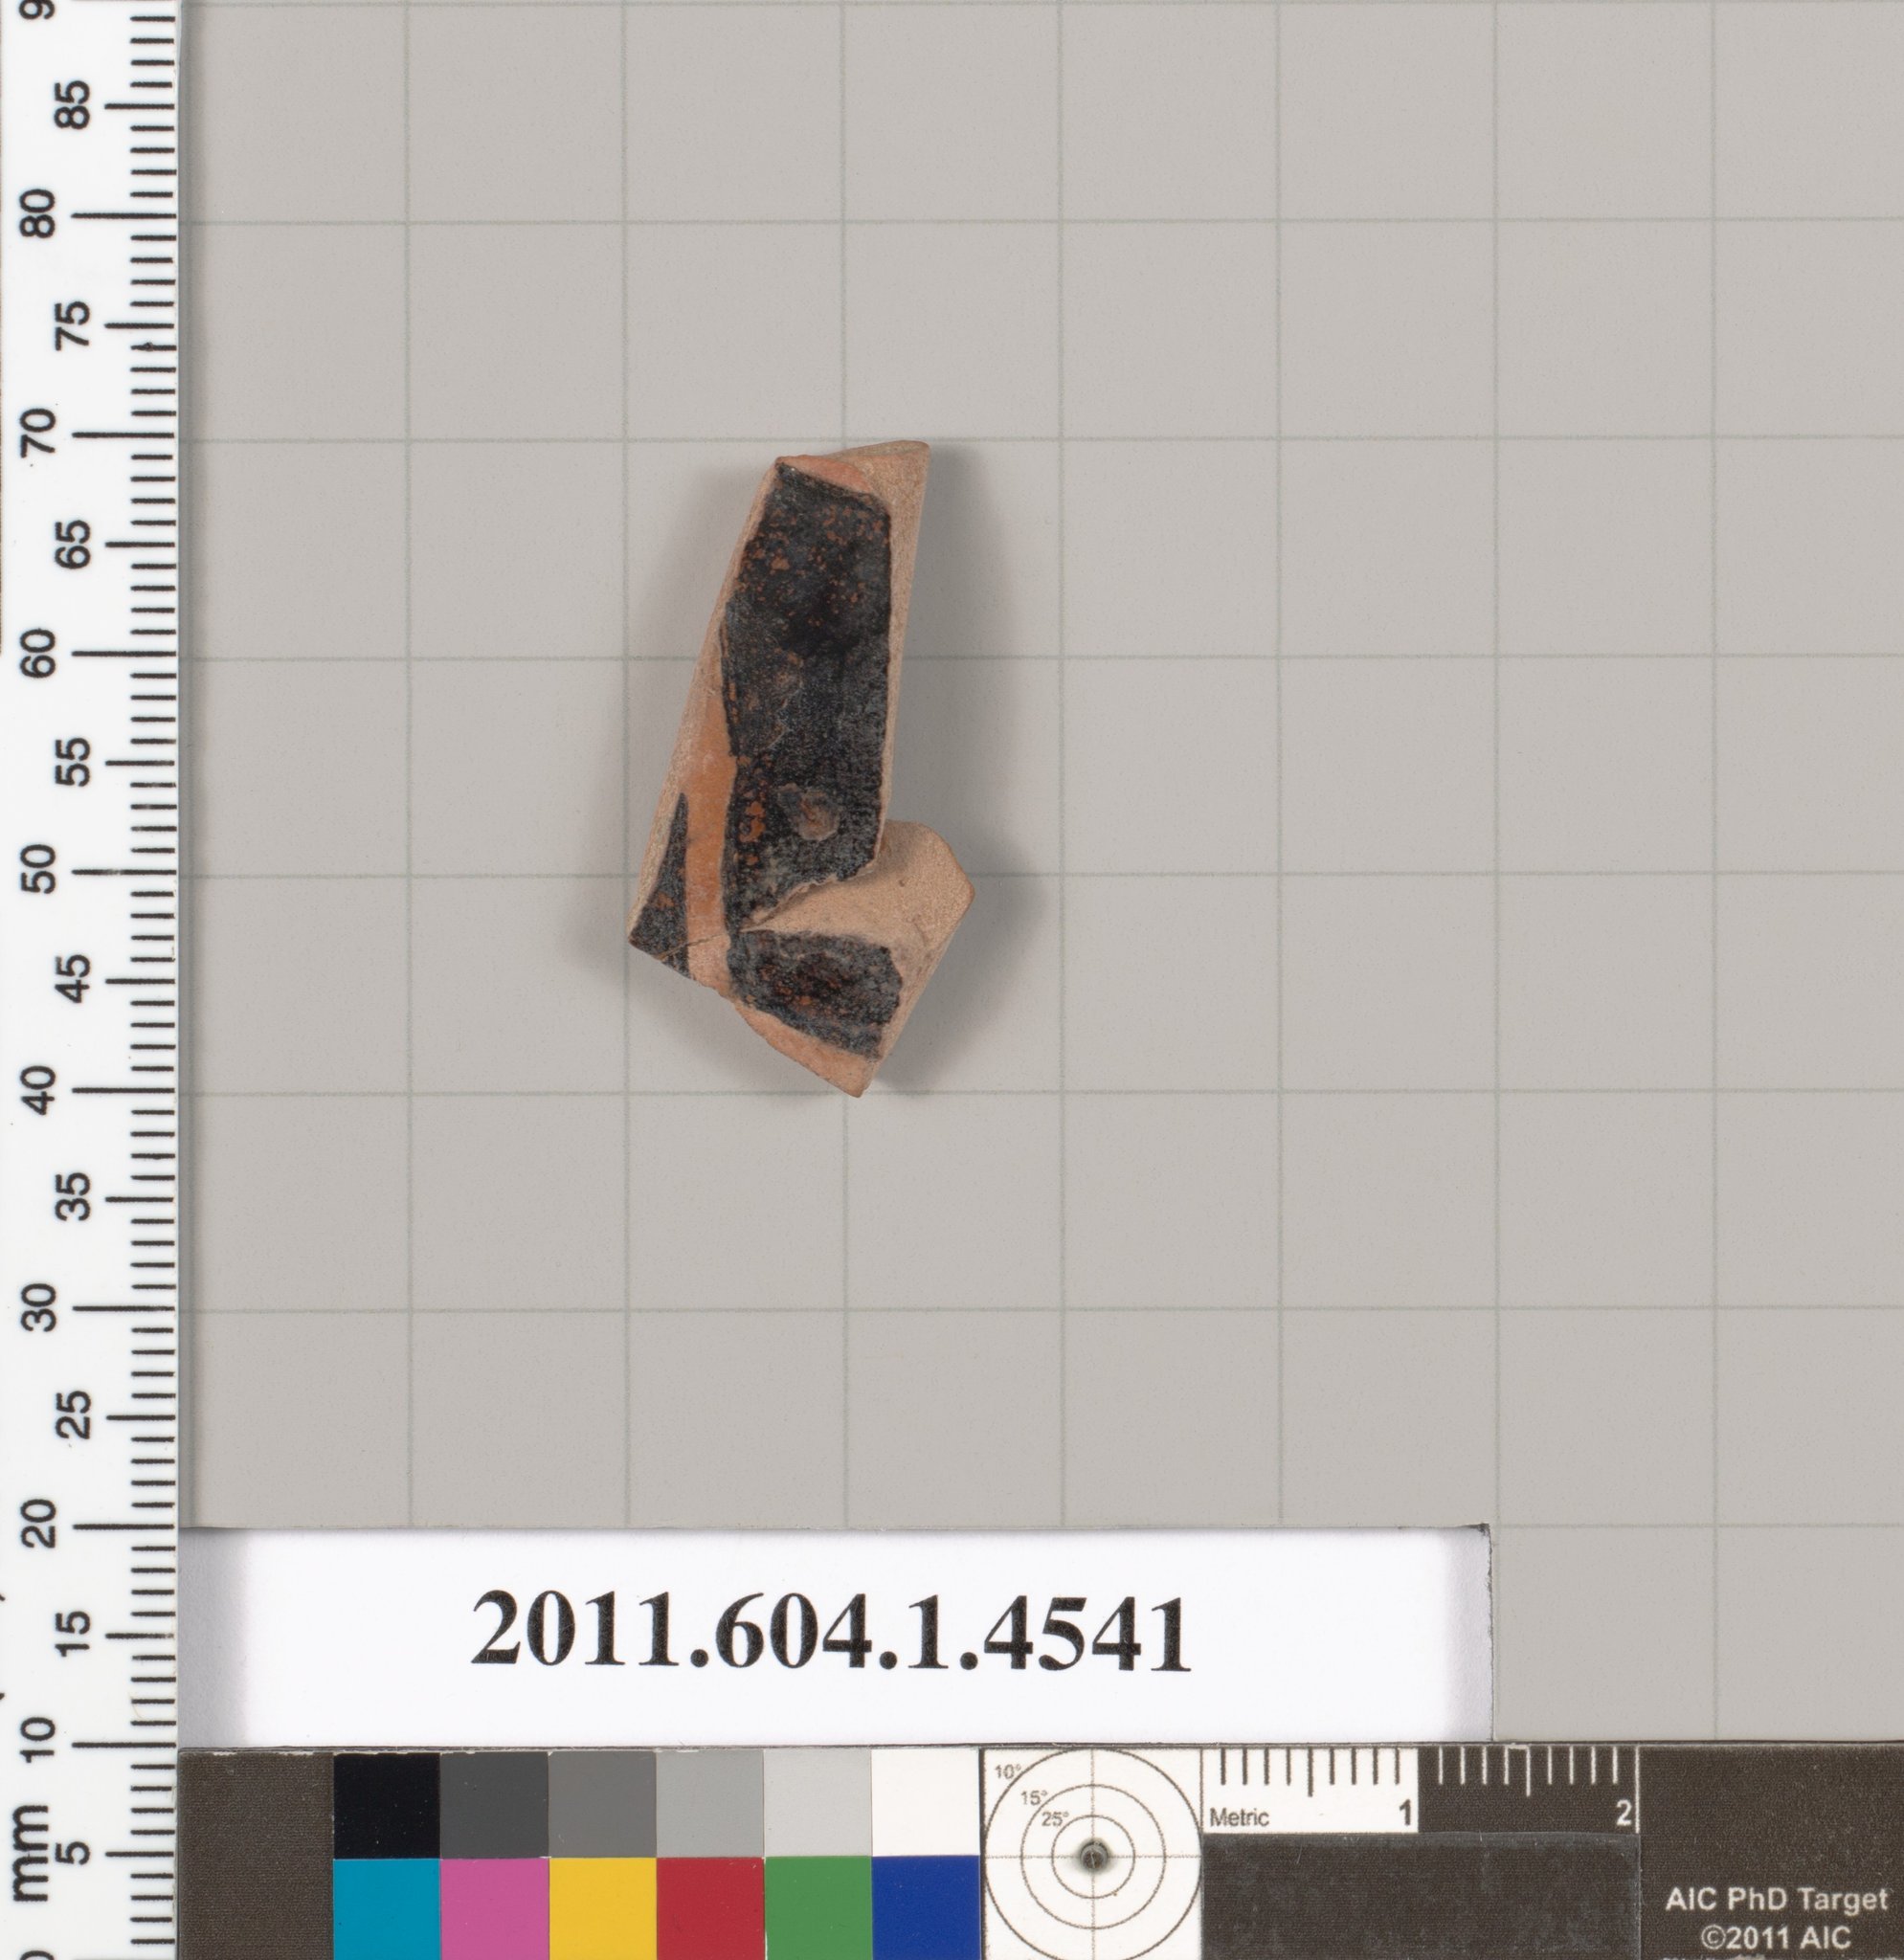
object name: kylix fragment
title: Terracotta fragment of a kylix (drinking cup)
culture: greek, attic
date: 500-451 BCE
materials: terracotta